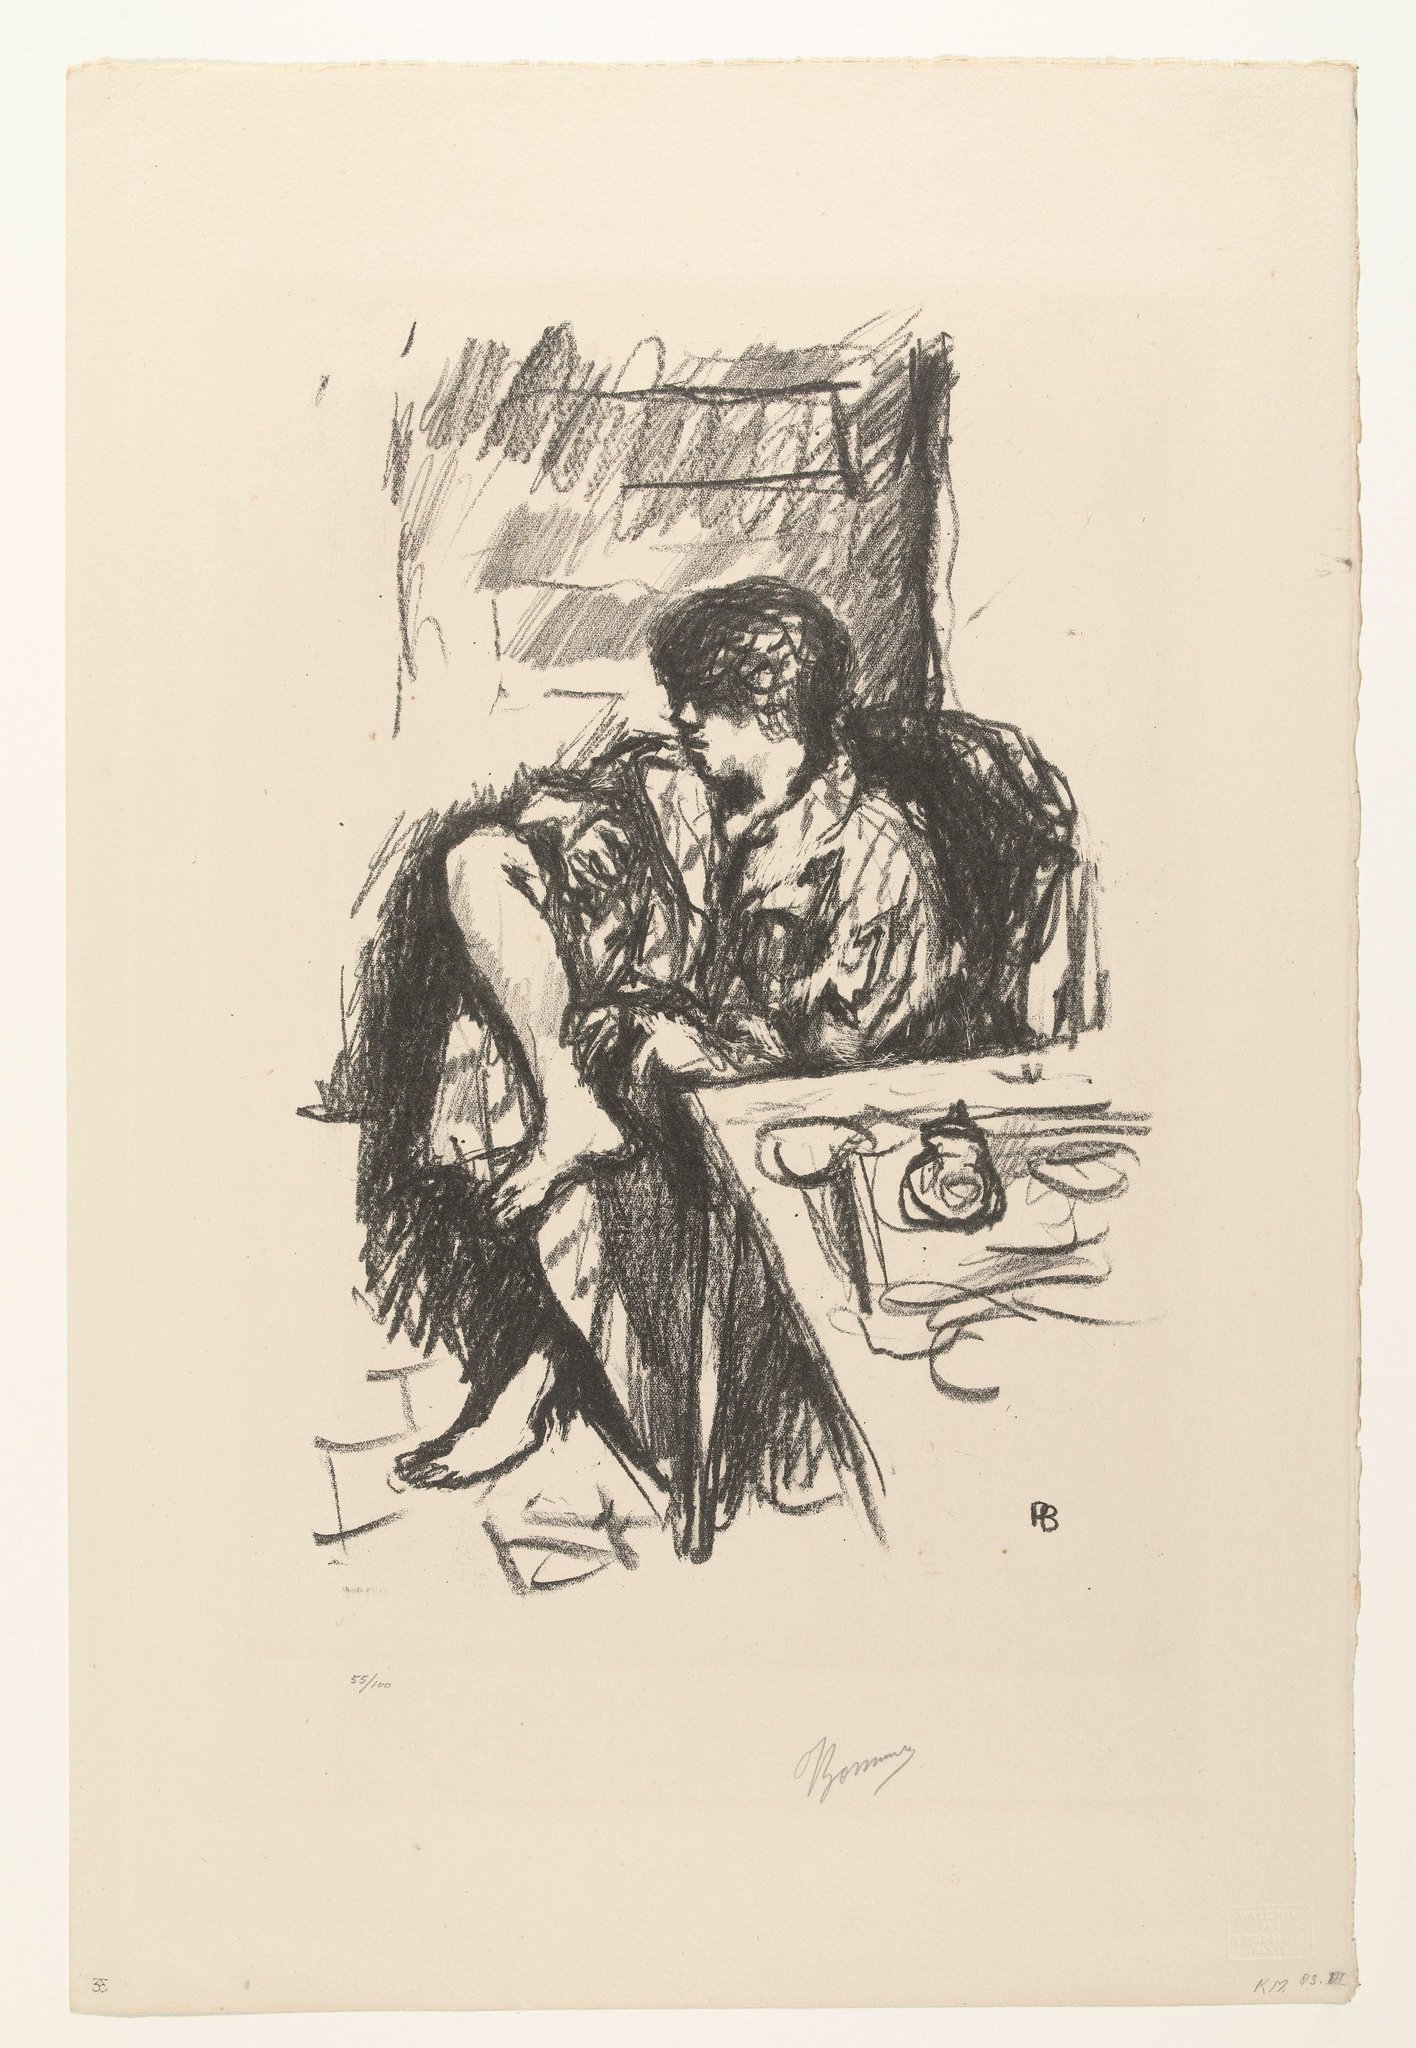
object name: print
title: Zittende vrouw kleedt zich aan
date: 1925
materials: paper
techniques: lithograph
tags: female sex; woman, putting on or taking off stockings, dressing oneself, getting dressed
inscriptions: collector's mark: Lugt 2228, collector's mark, collector's mark: Lugt 2760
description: Blad uit: Album Bonnard des Maîtres et petits maîtres d'aujourd'hui, Edmond Frapier (uitgever), Parijs 1925.